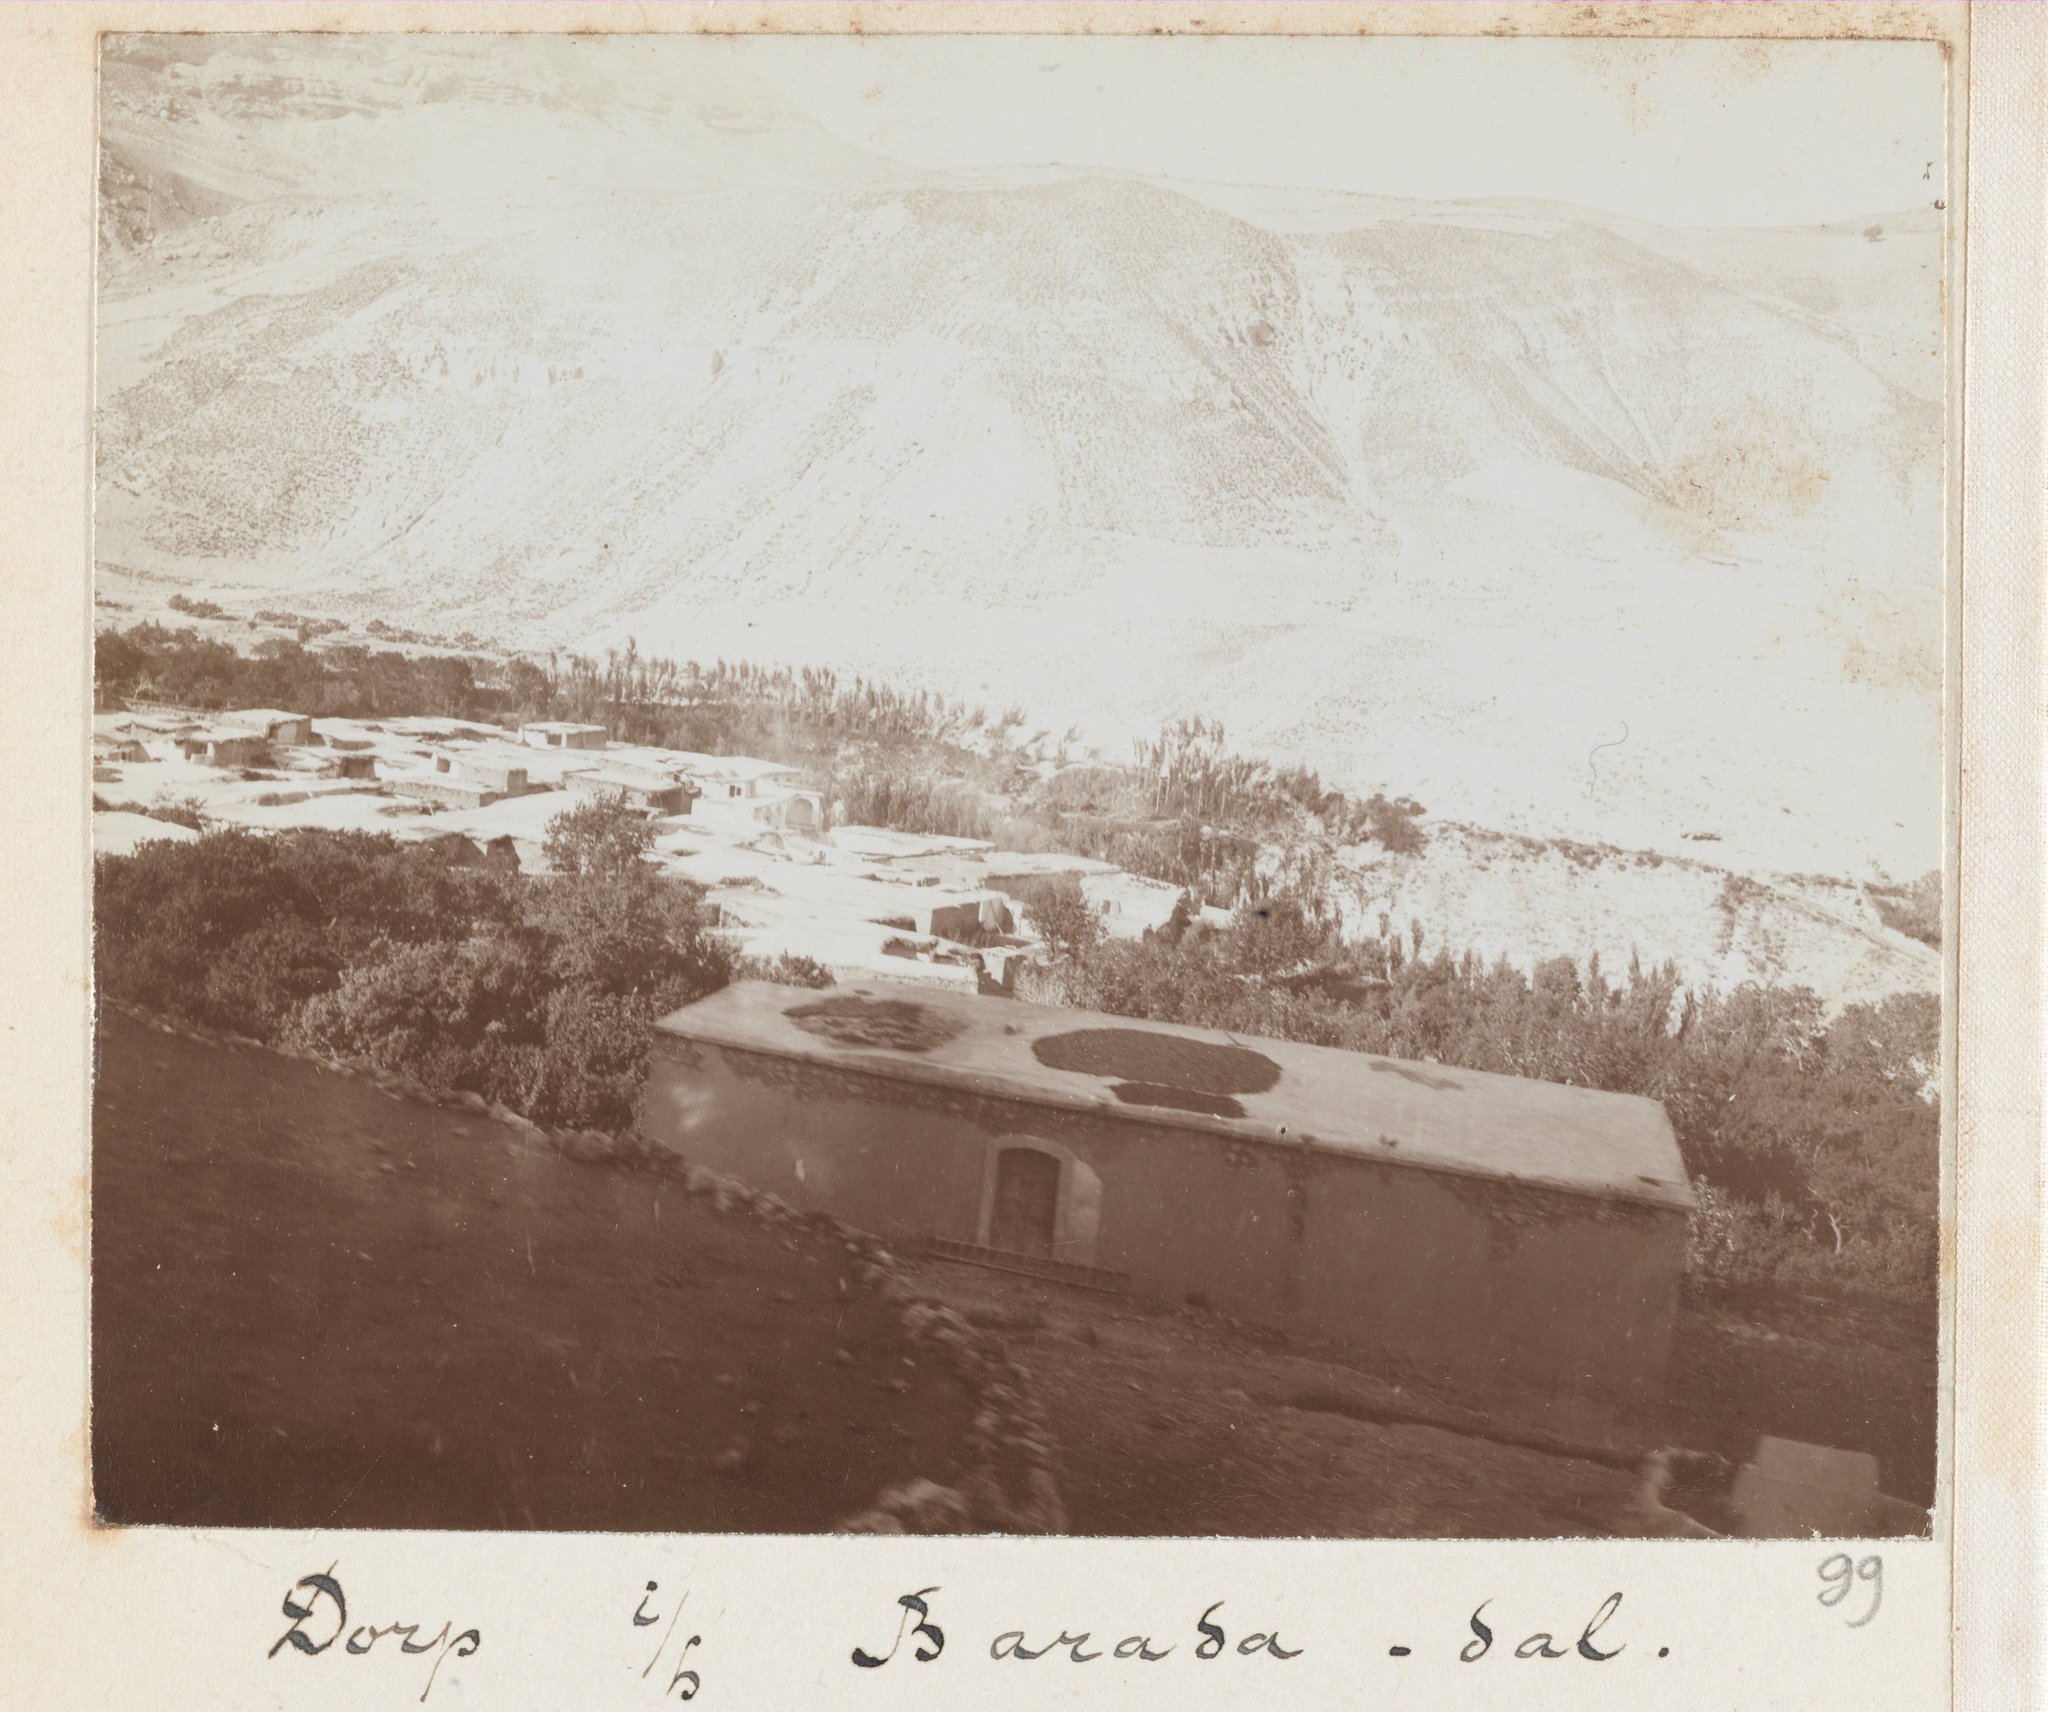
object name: page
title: Dorp in het dal van de Barada bij de Anti-Libanon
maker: johannes lodewijk heldring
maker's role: fotograaf, predikant, schrijver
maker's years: 1852-1923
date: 1898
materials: paper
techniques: collodion silver print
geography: anti-libanon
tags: village